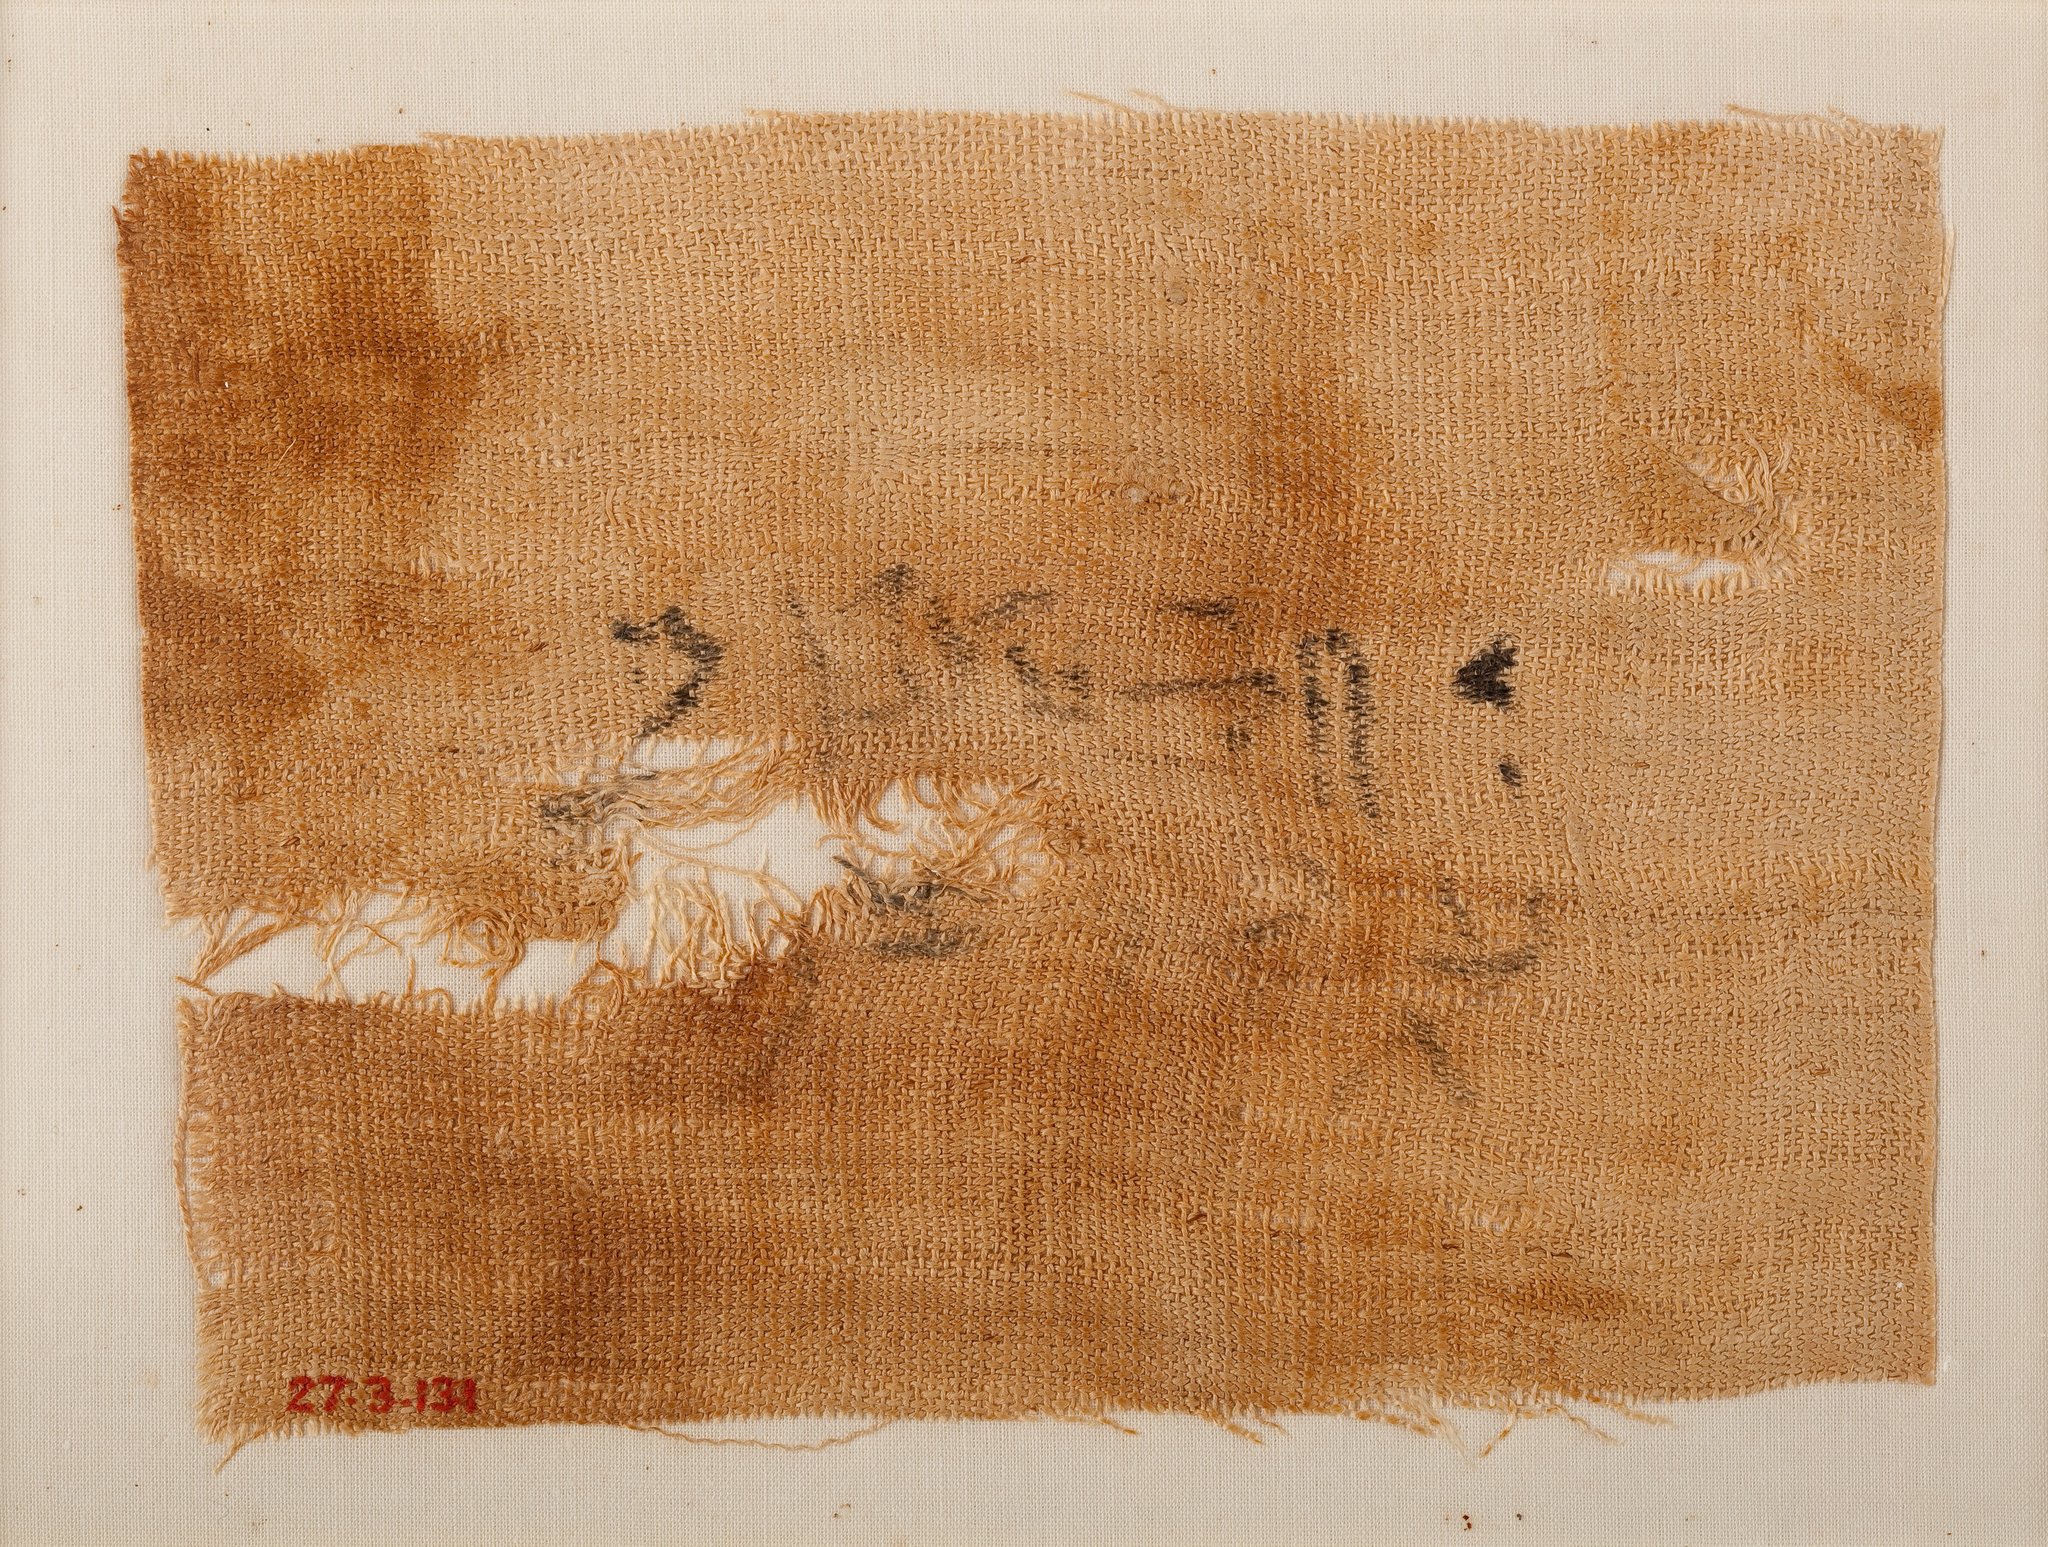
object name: linen mark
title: Linen mark (Type XXXIV)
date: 1961-1917 BCE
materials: linen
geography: egypt